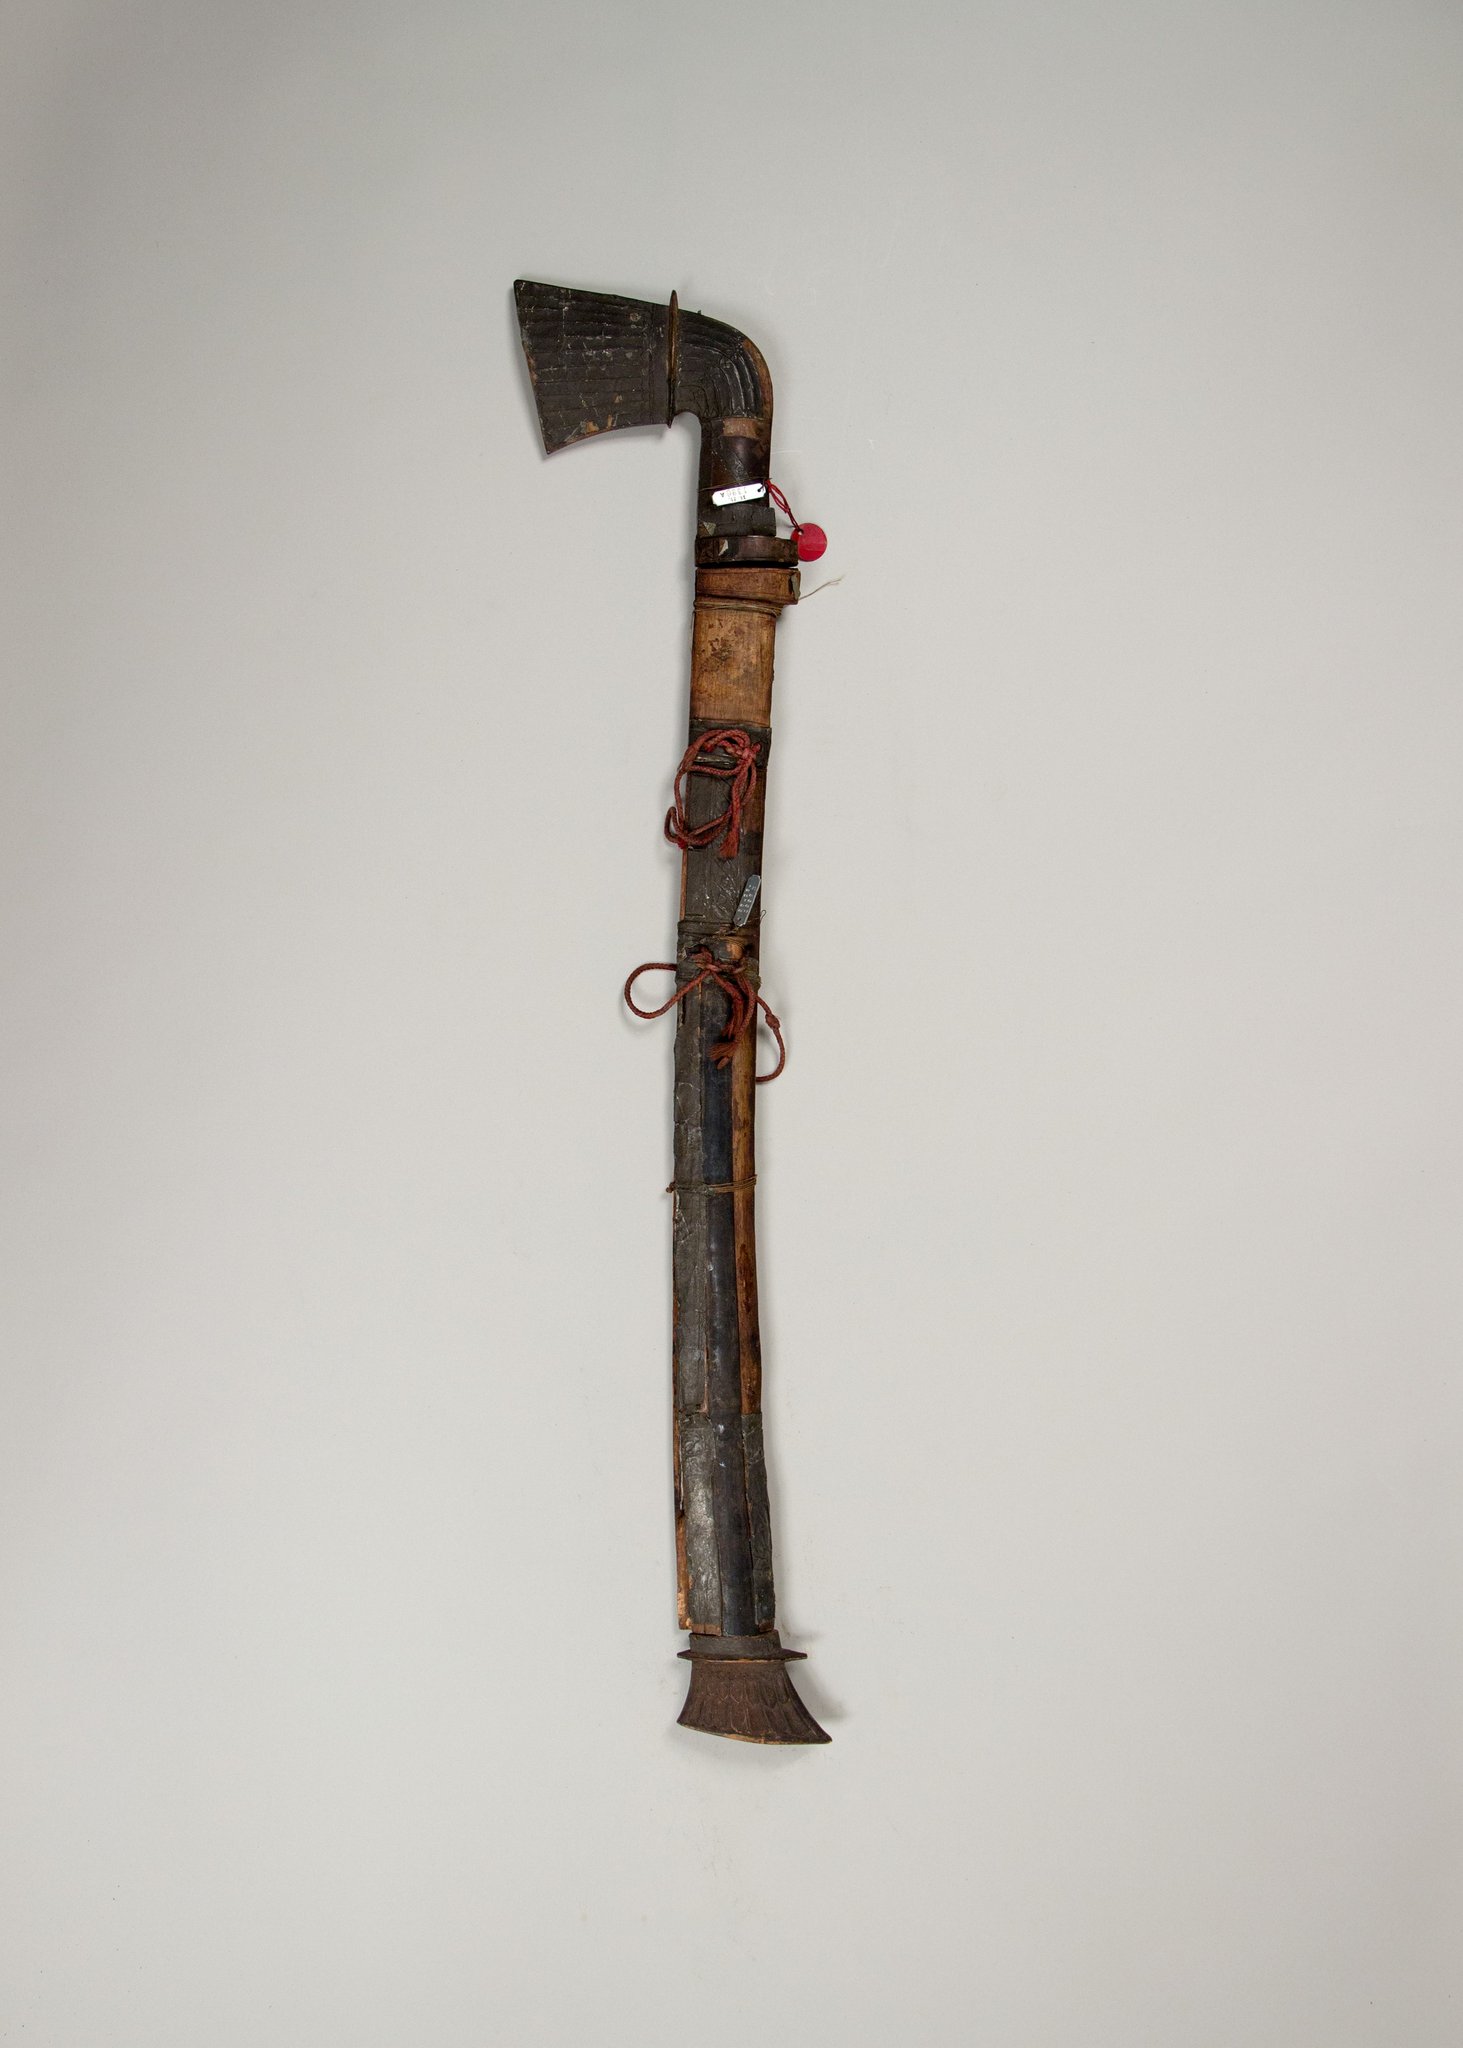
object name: sword with scabbard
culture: indonesian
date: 1701-1900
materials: foil, tin, wood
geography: indonesia